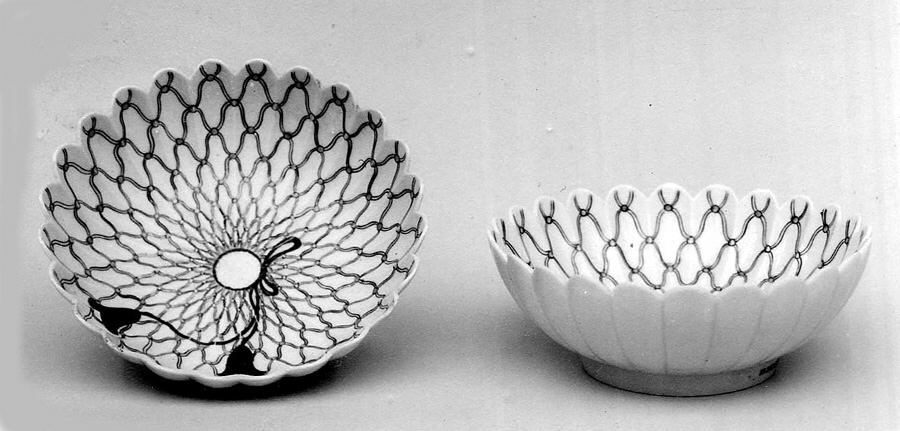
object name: bowl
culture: japanese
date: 1820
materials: enamel, porcelain